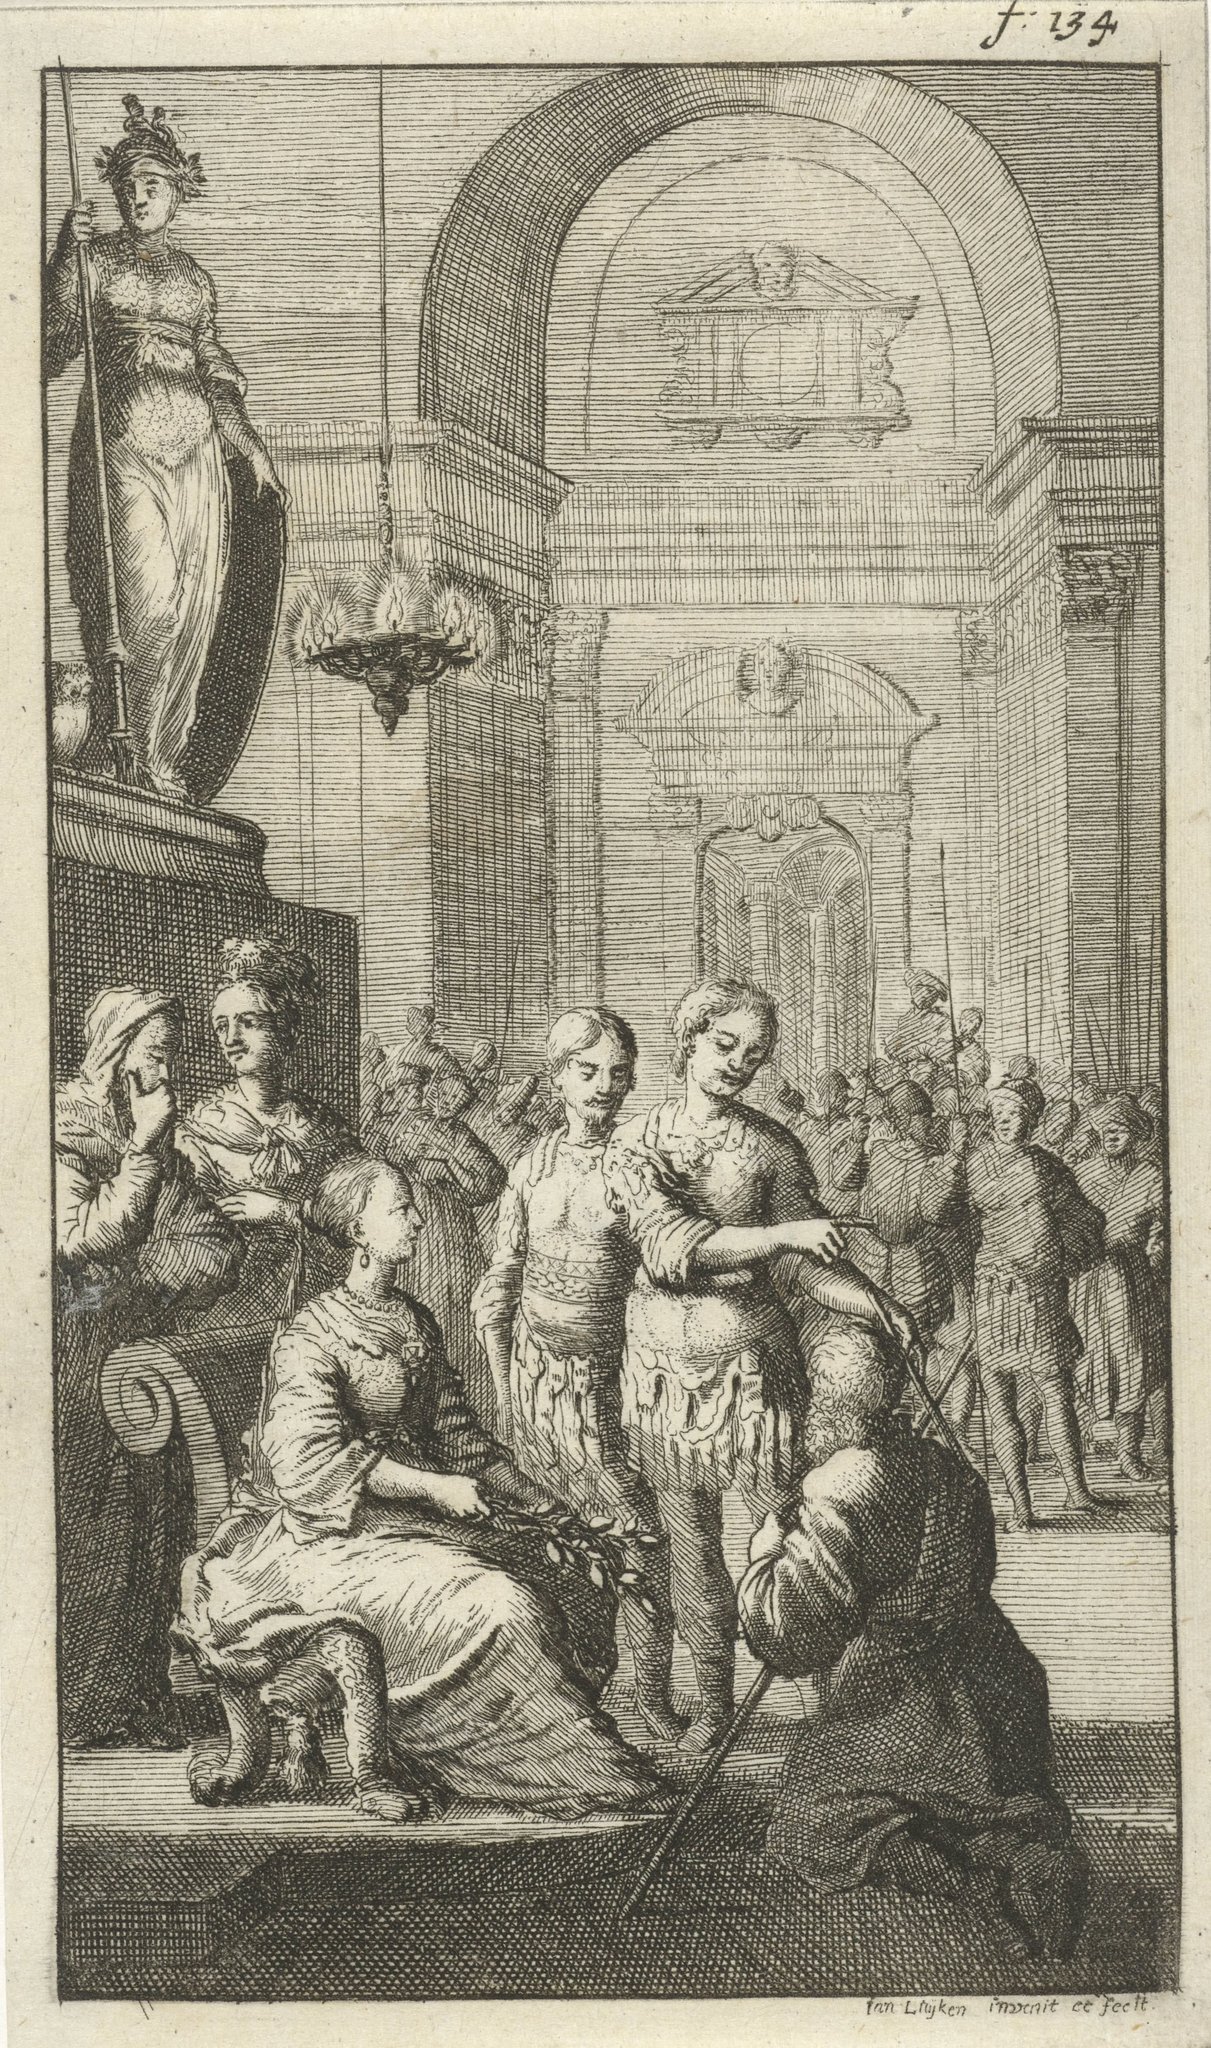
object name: book illustration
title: Poliarchus knielt voor Argenis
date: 1680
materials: paper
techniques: etching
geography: amsterdam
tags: kneeling figure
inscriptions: collector's mark: Lugt 2228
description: Illustratie opgenomen in het eerste deel van: Barclay, John. D'Argenis, 2 delen. Amsterdam: Jan Claesz ten Hoorn, 1680-1681.